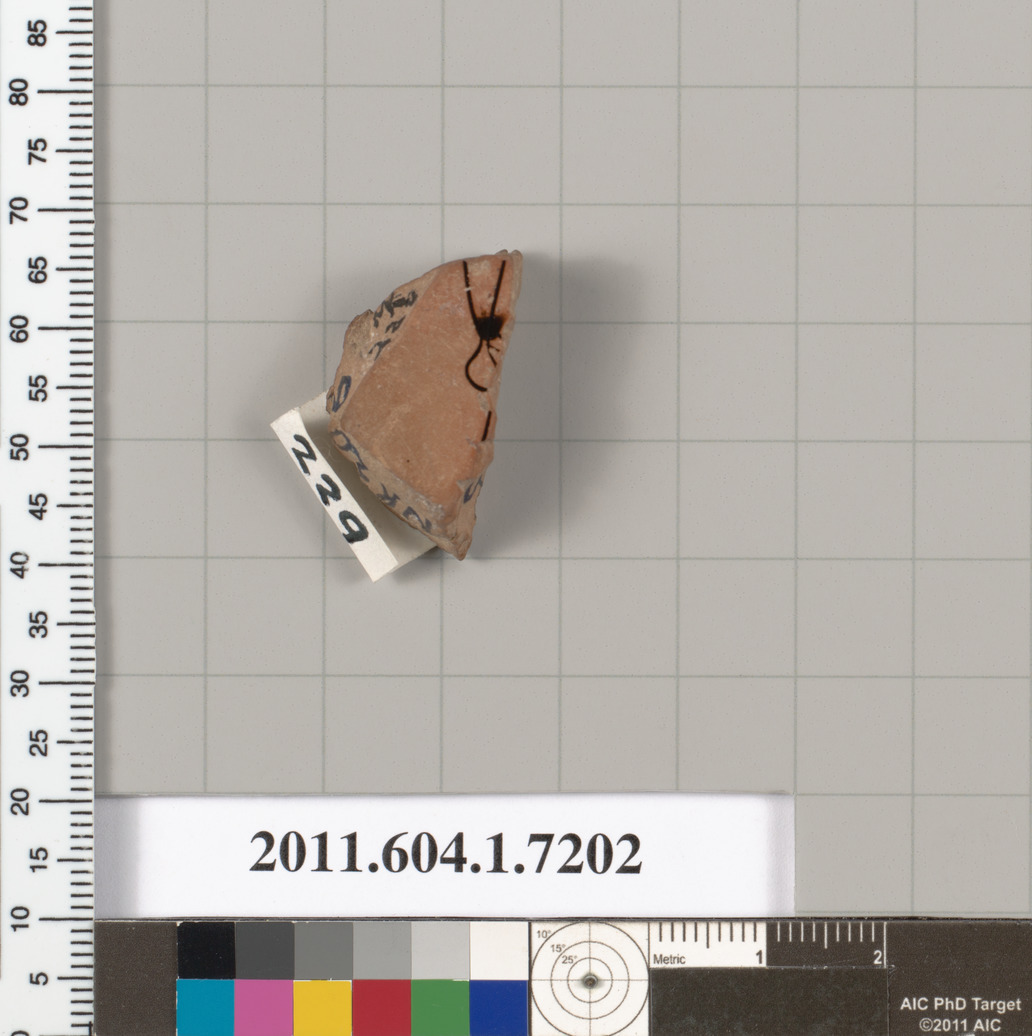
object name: kylix fragment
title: Terracotta fragment of a kylix (drinking cup)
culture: greek, attic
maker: makron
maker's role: artist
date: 500-480 BCE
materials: terracotta